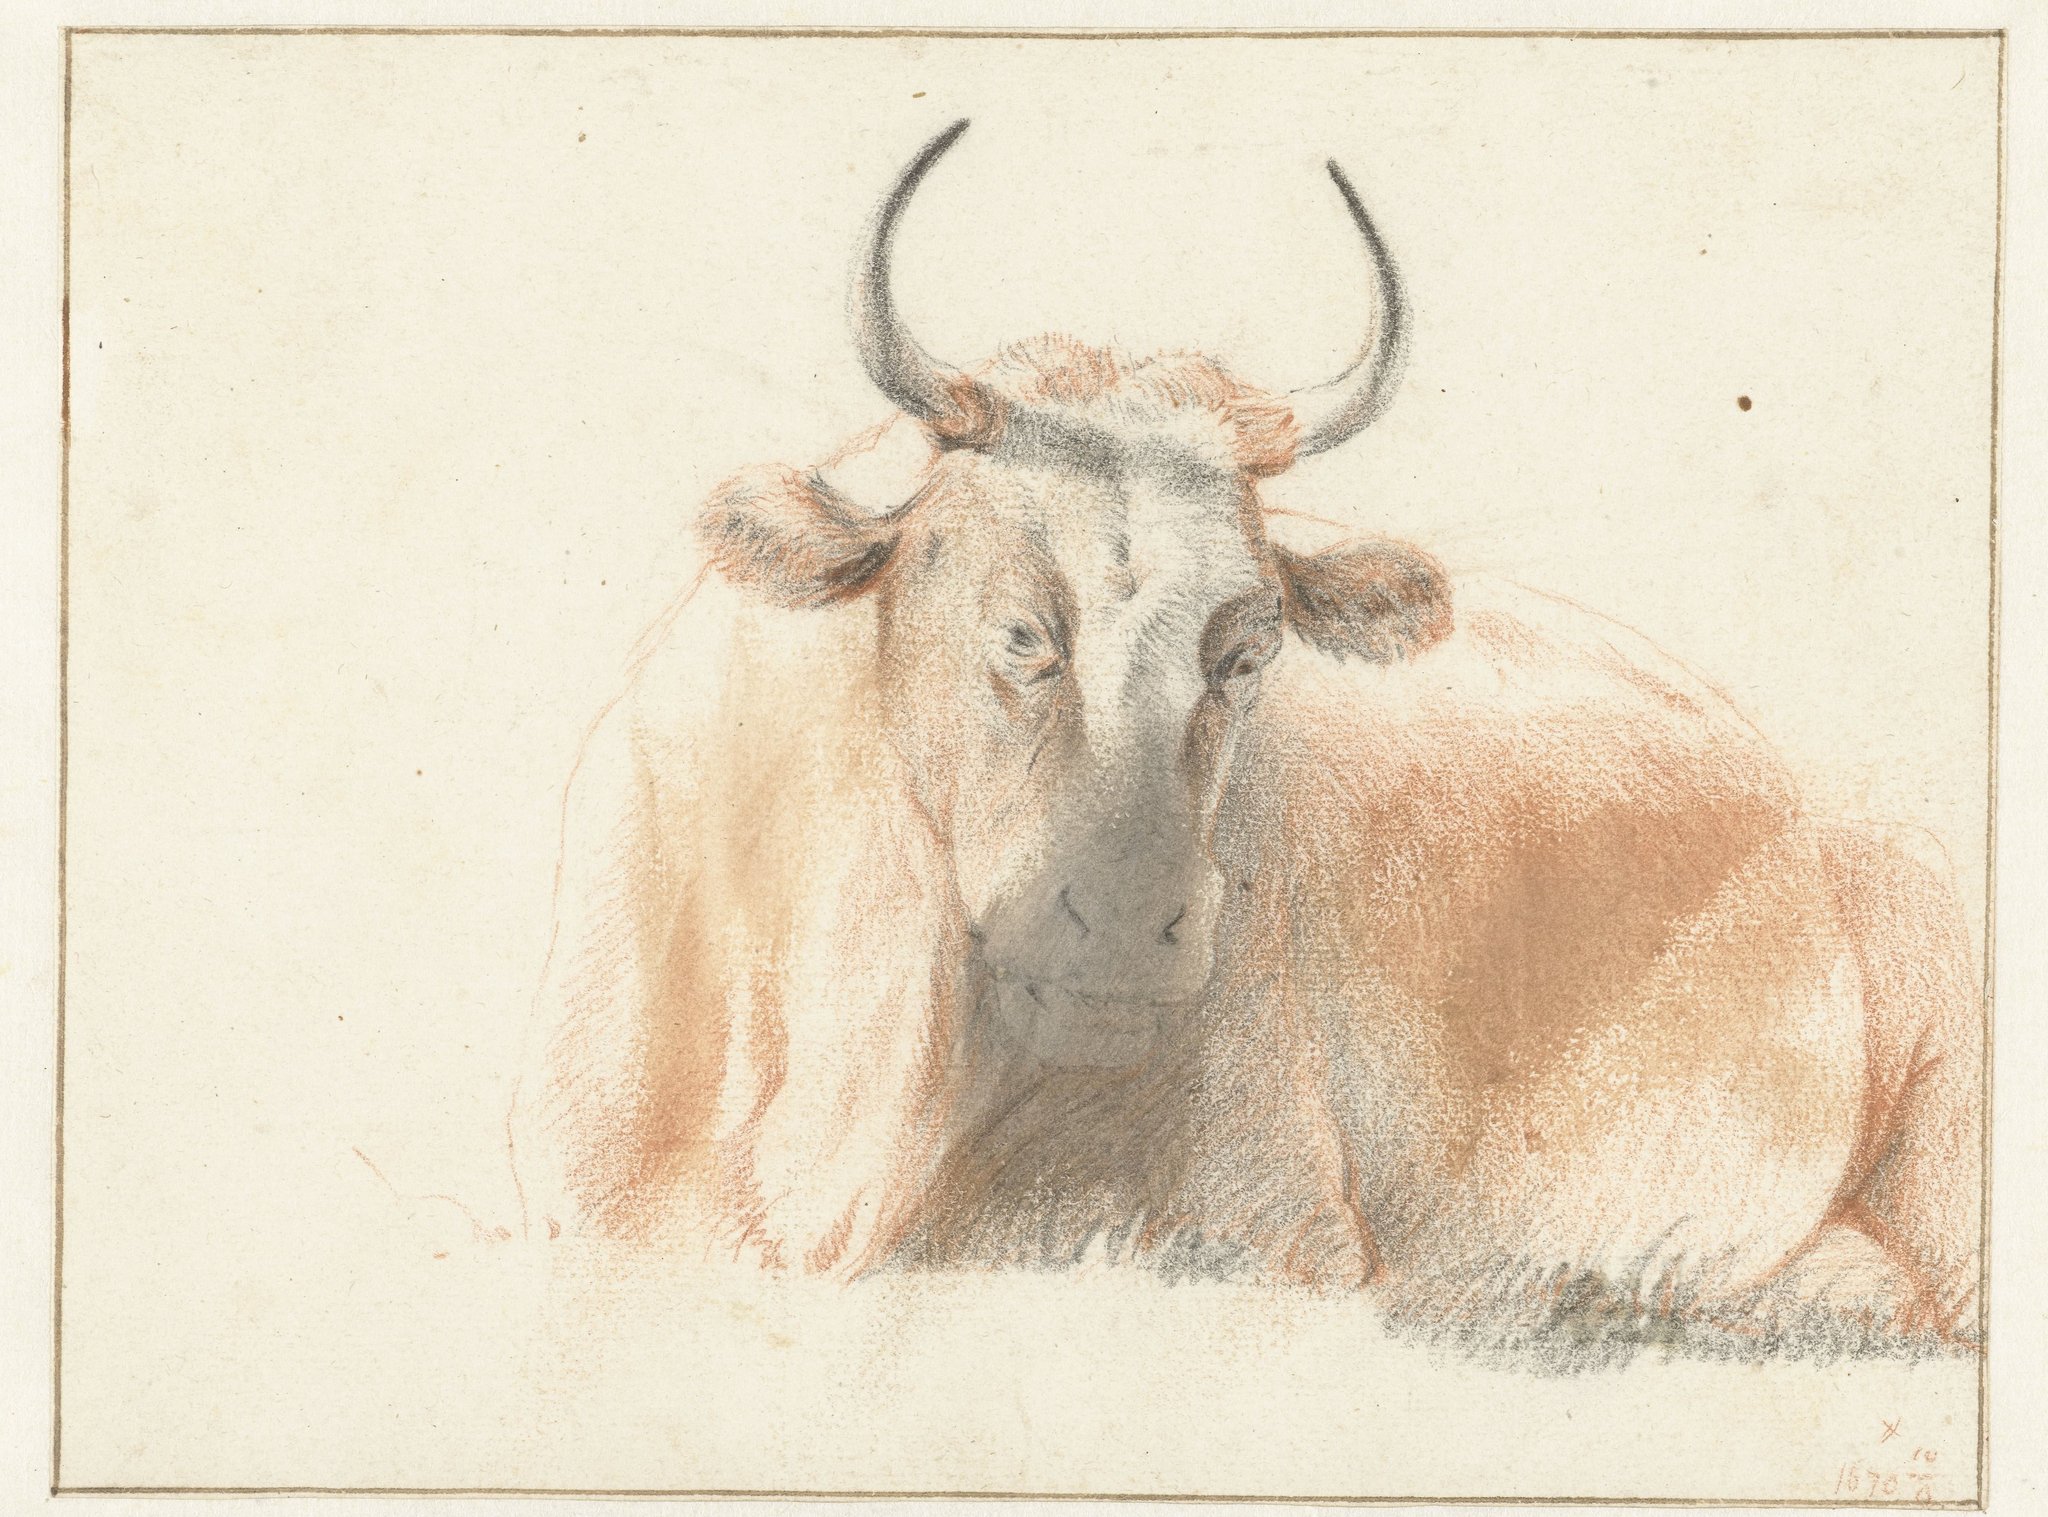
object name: drawing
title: Liggende koe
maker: jan de bray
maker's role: draughtsman, print maker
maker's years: 1627-1697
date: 1670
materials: chalk, paper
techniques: brush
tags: cow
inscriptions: date: ‘1670 10/9’